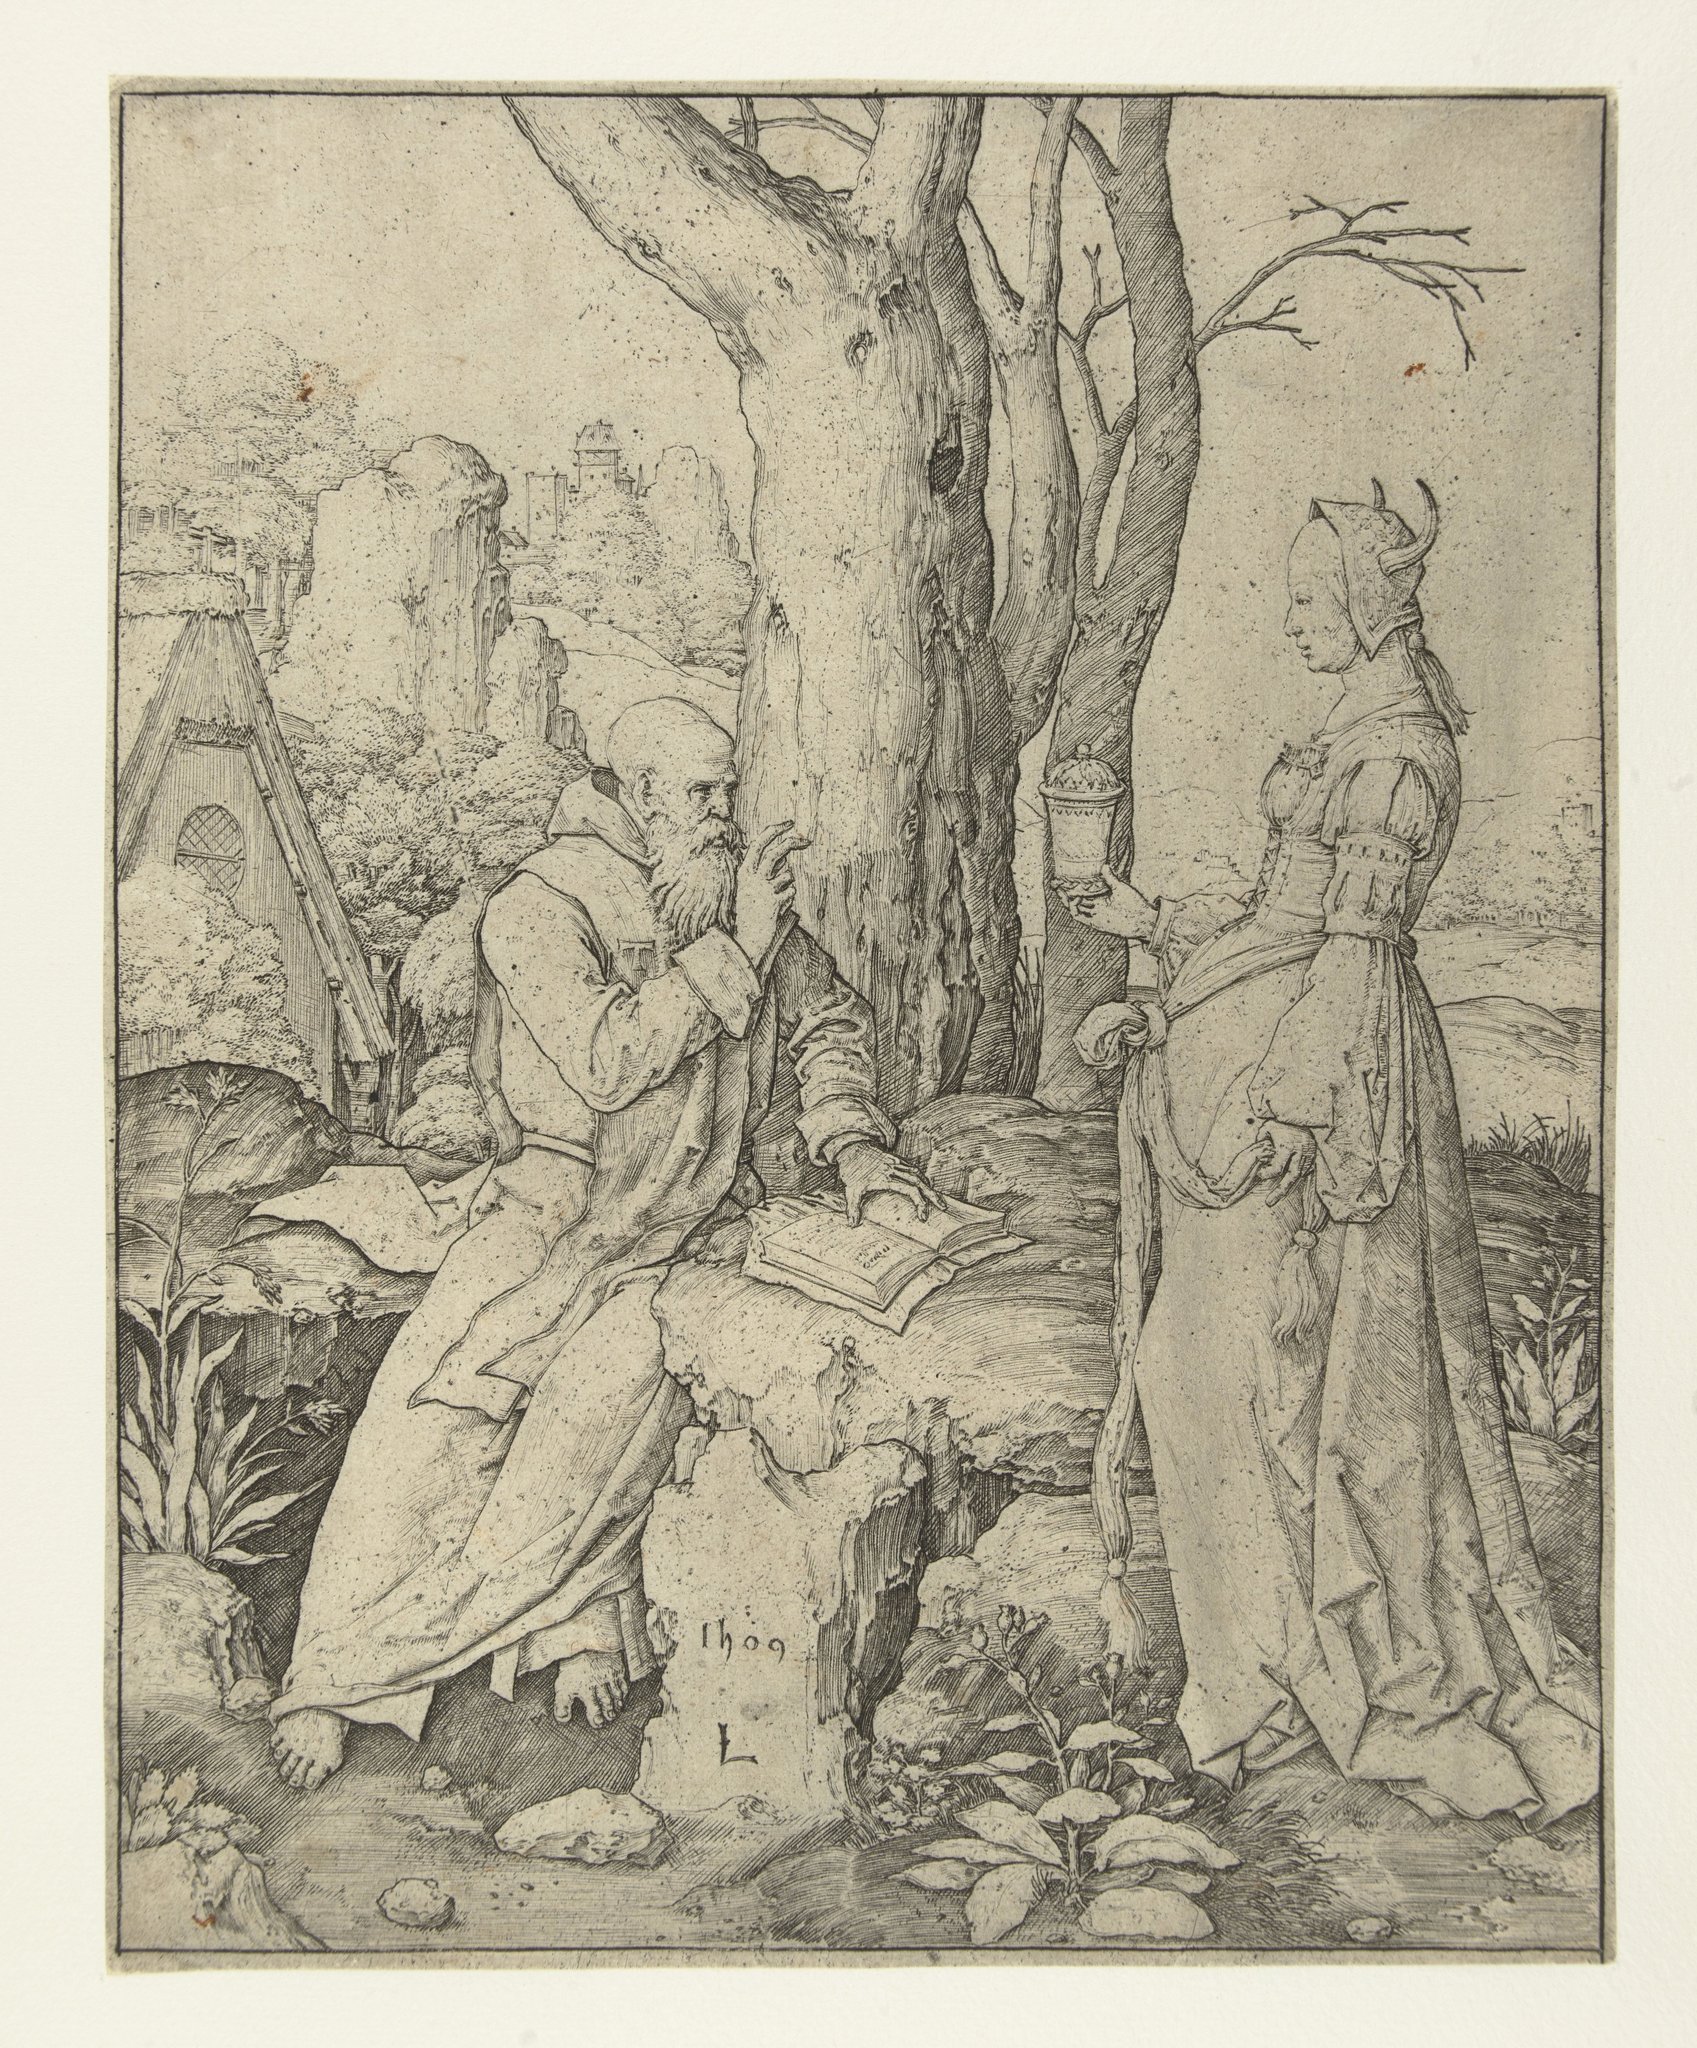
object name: print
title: De verzoeking van de heilige Antonius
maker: lucas van leyden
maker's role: draughtsman, painter, print maker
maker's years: 1494-1533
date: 1509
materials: paper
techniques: engraving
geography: low countries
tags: temptations of st. antony abbot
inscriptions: collector's mark: Lugt 2228a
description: Heilige Antonius zittend in landschap met boek, voor hem staat een vrouw met horens op het hoofd en een pot in de rechterhand.